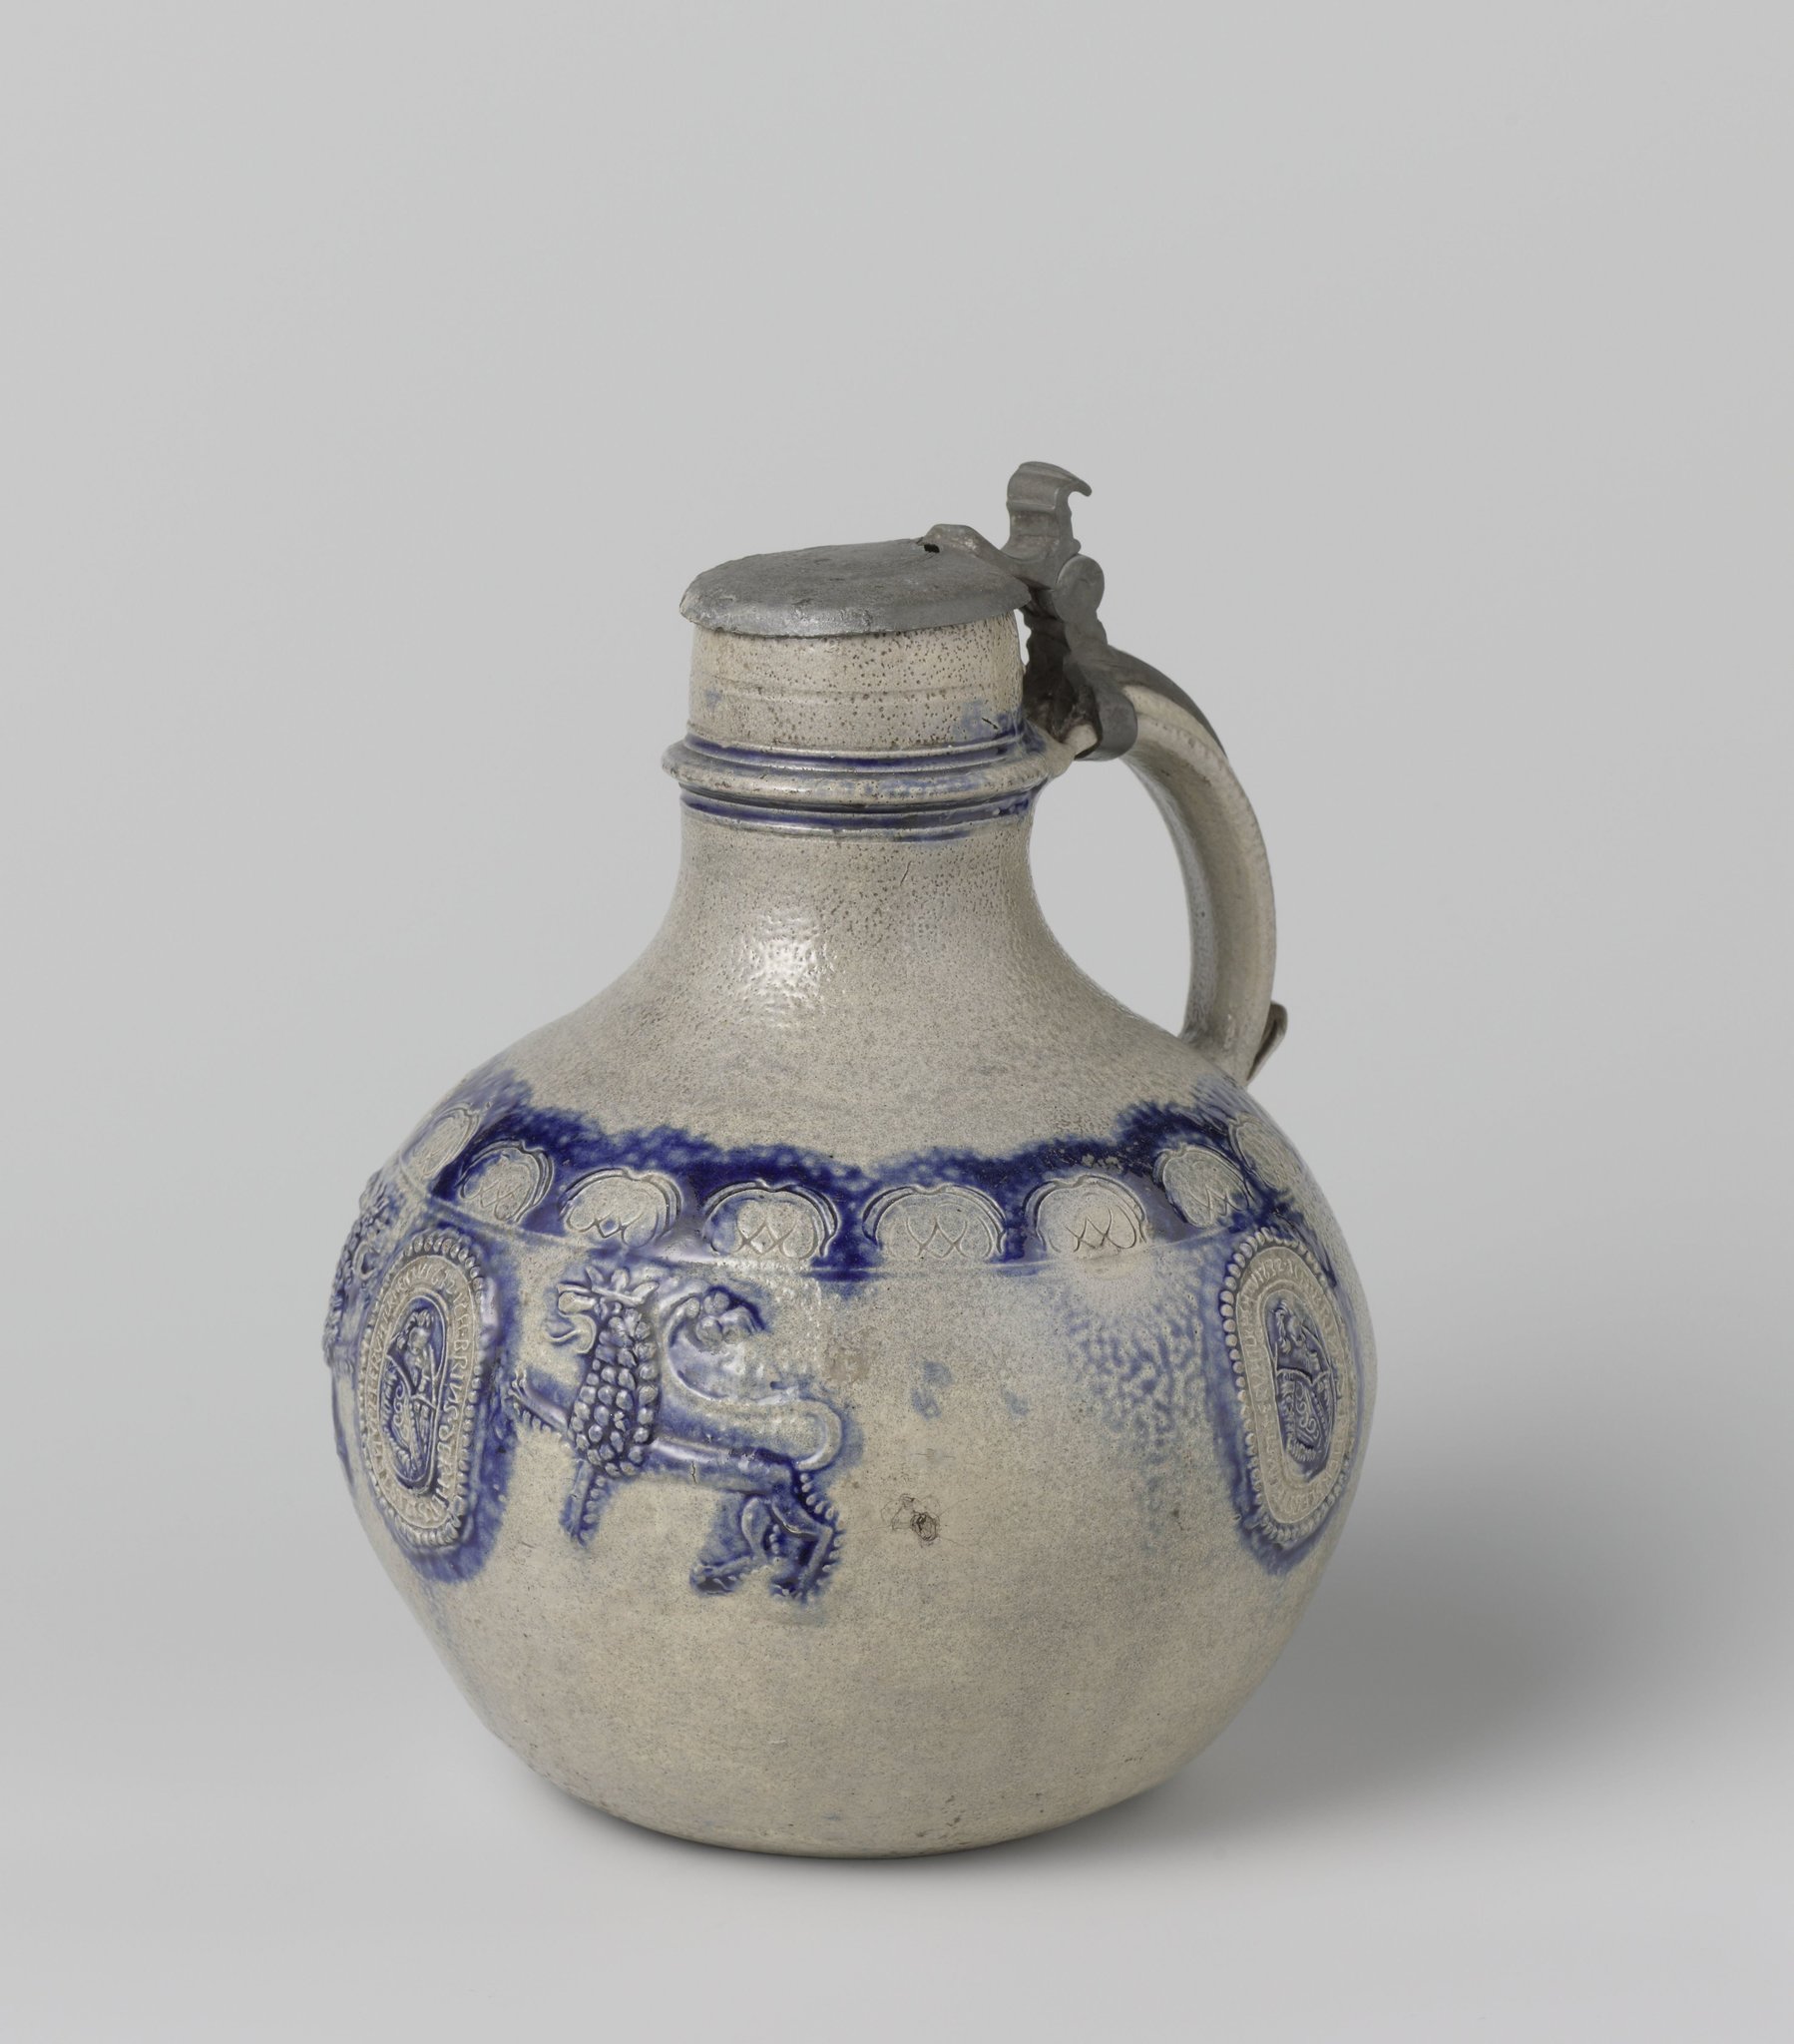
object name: jug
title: Jug with a portrait and lions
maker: Anonymous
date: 1632-1650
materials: cobalt, glaze, stoneware, tin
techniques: firing, forming, relief, turning, vitrification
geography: westerwald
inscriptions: inscription: ‘ICH.BRINS.DER.HERS.LEBSTENVM.I.ERVNT[...].1632’, mark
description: Kruik van steengoed op standring met een bolvormige buik en smalle nek. Het C-vormige oor is bevestigd aan de nek en schouder. Profielen op de nek. Gedeeltelijk bedekt met kobaltblauw. Op de schouder een ingegrifte lijn met daarboven een band met gestempelde halve cirkels tegen een blauwe achtergrond. De buik met in reliëf drie gedrukte en opgelegde medaillons, de middelste geflankeerd door gekroonde leeuwen. In de medaillons een portret met als randschrift 'ICH.BRINS.DER.HERS.LEBSTENVM.I.ERVNT[...].1632'. Aan het oor is een montuur met deksel bevestigd. Aan de binnenzijde van de deksel een geslagen merk. Westerwald.